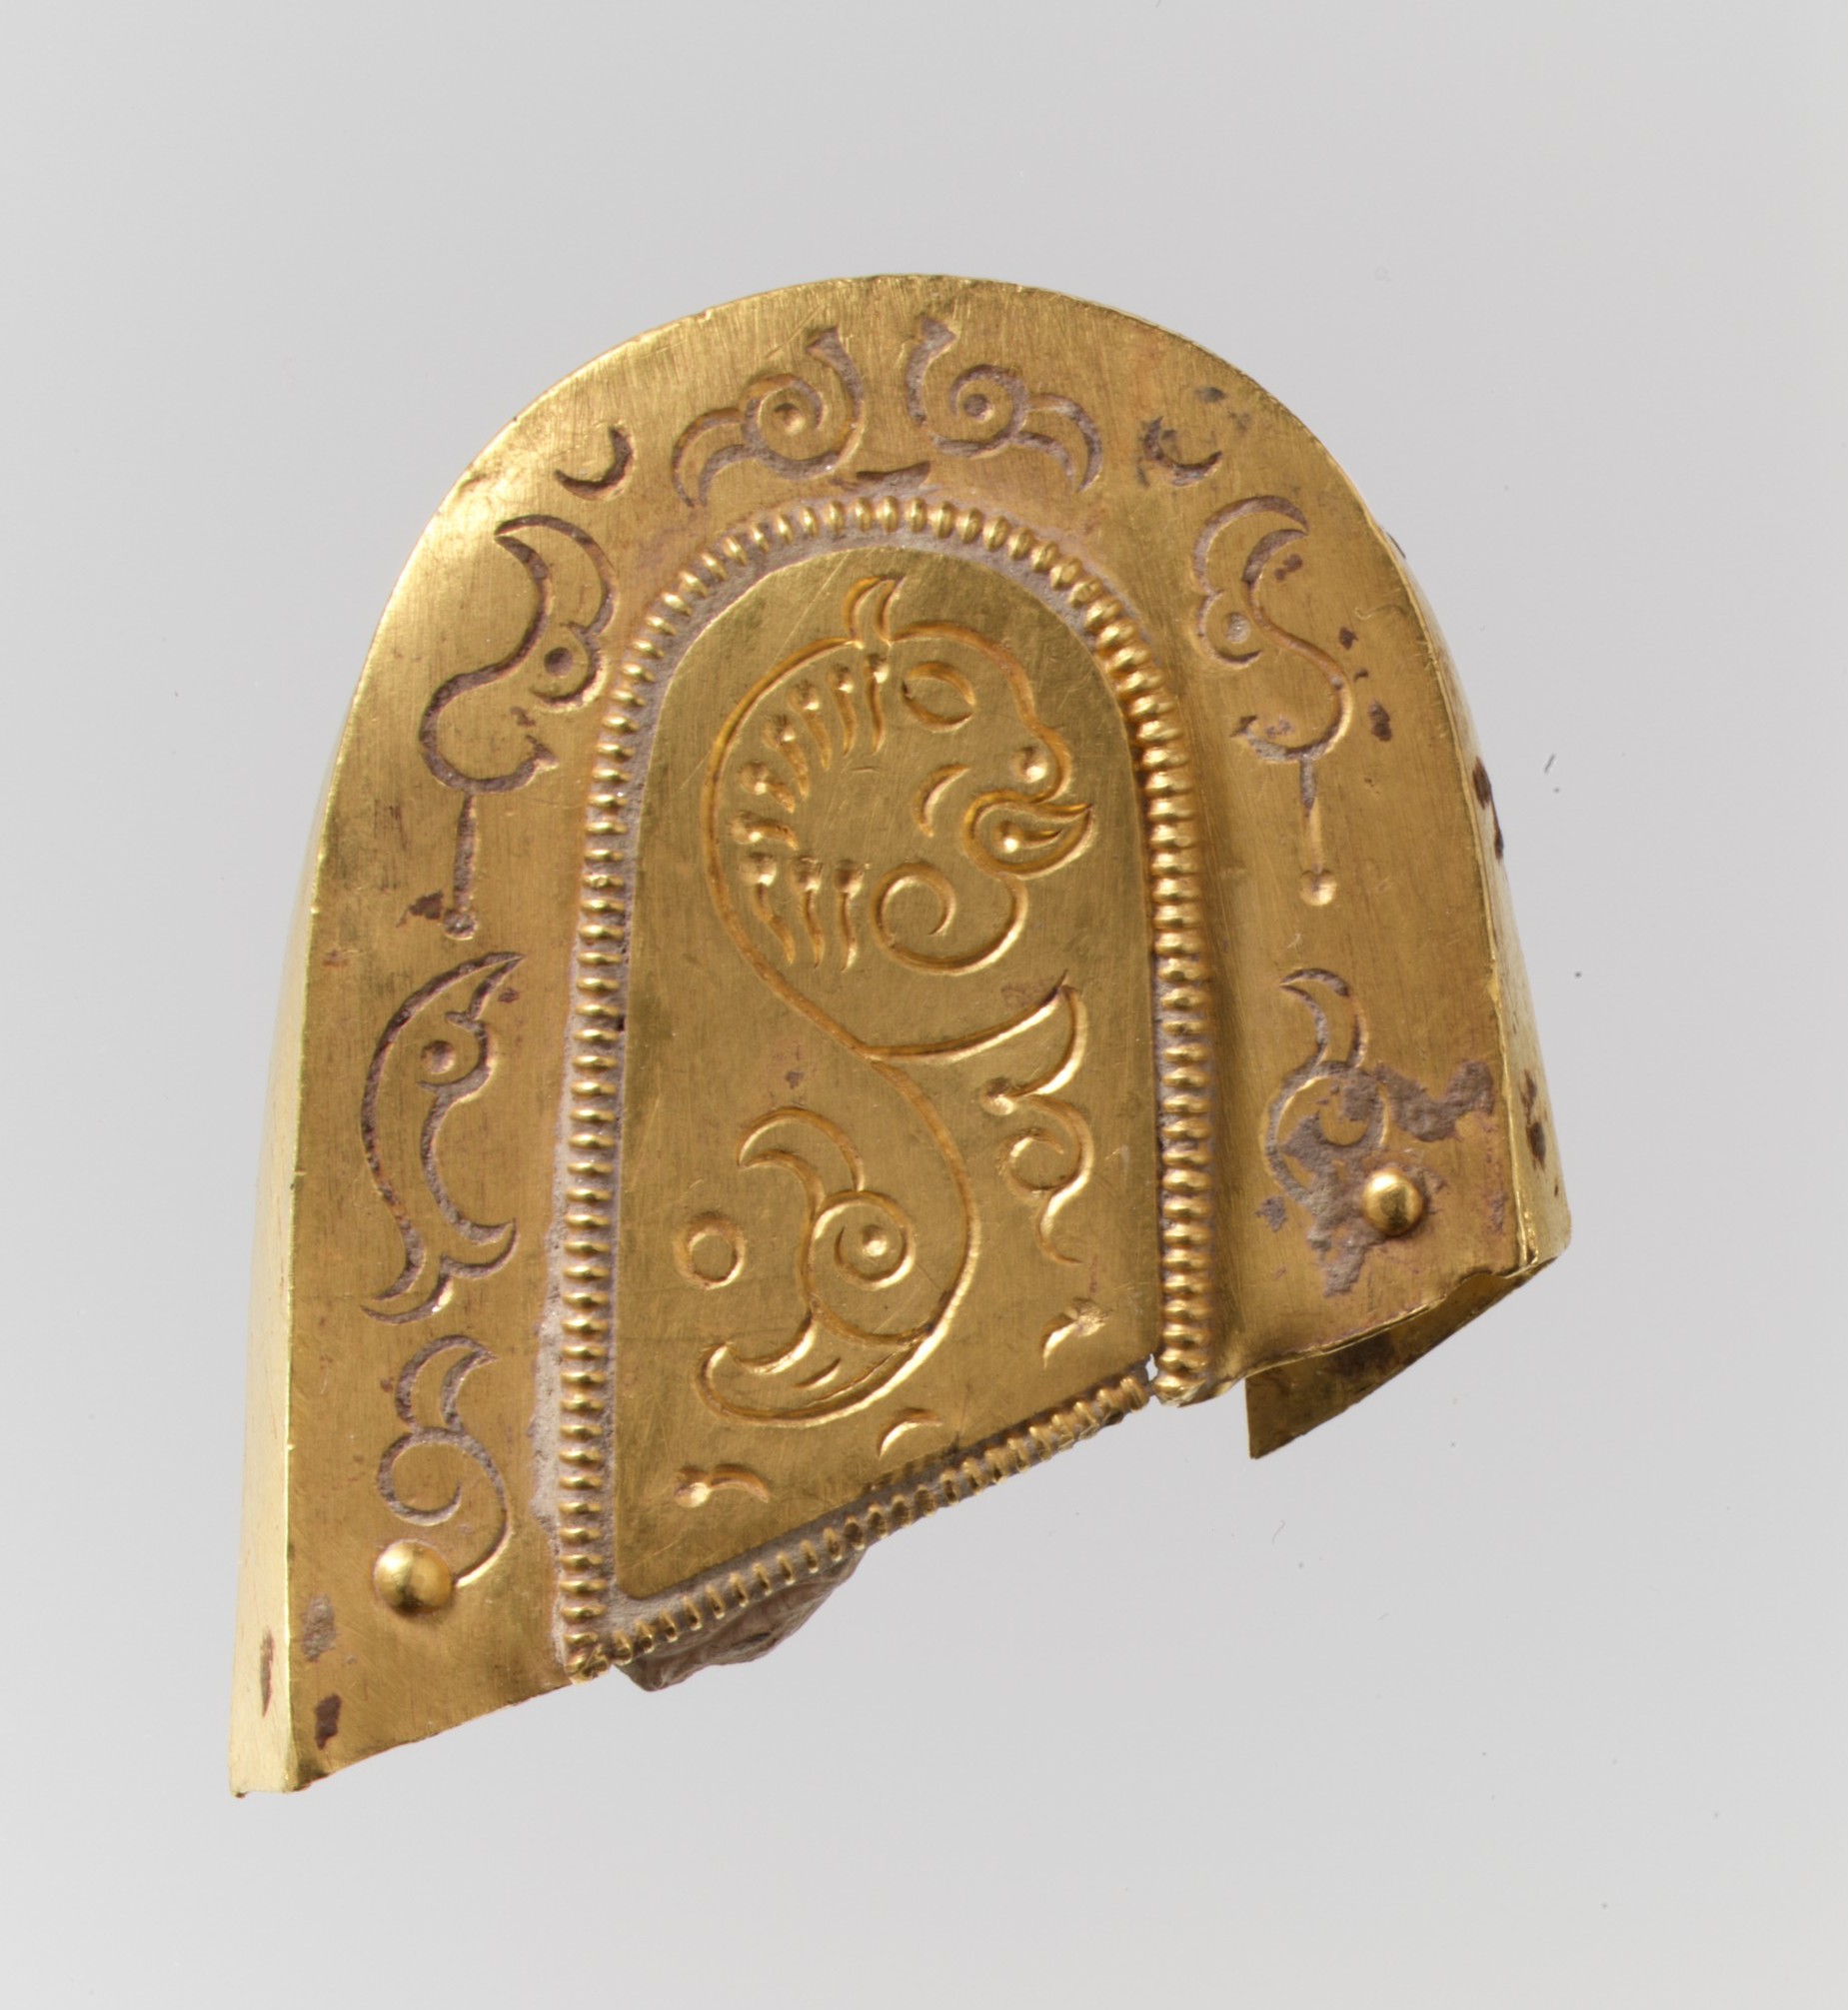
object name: sword with scabbard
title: Piece from a Luxury Iron Dagger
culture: langobardic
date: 600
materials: gold